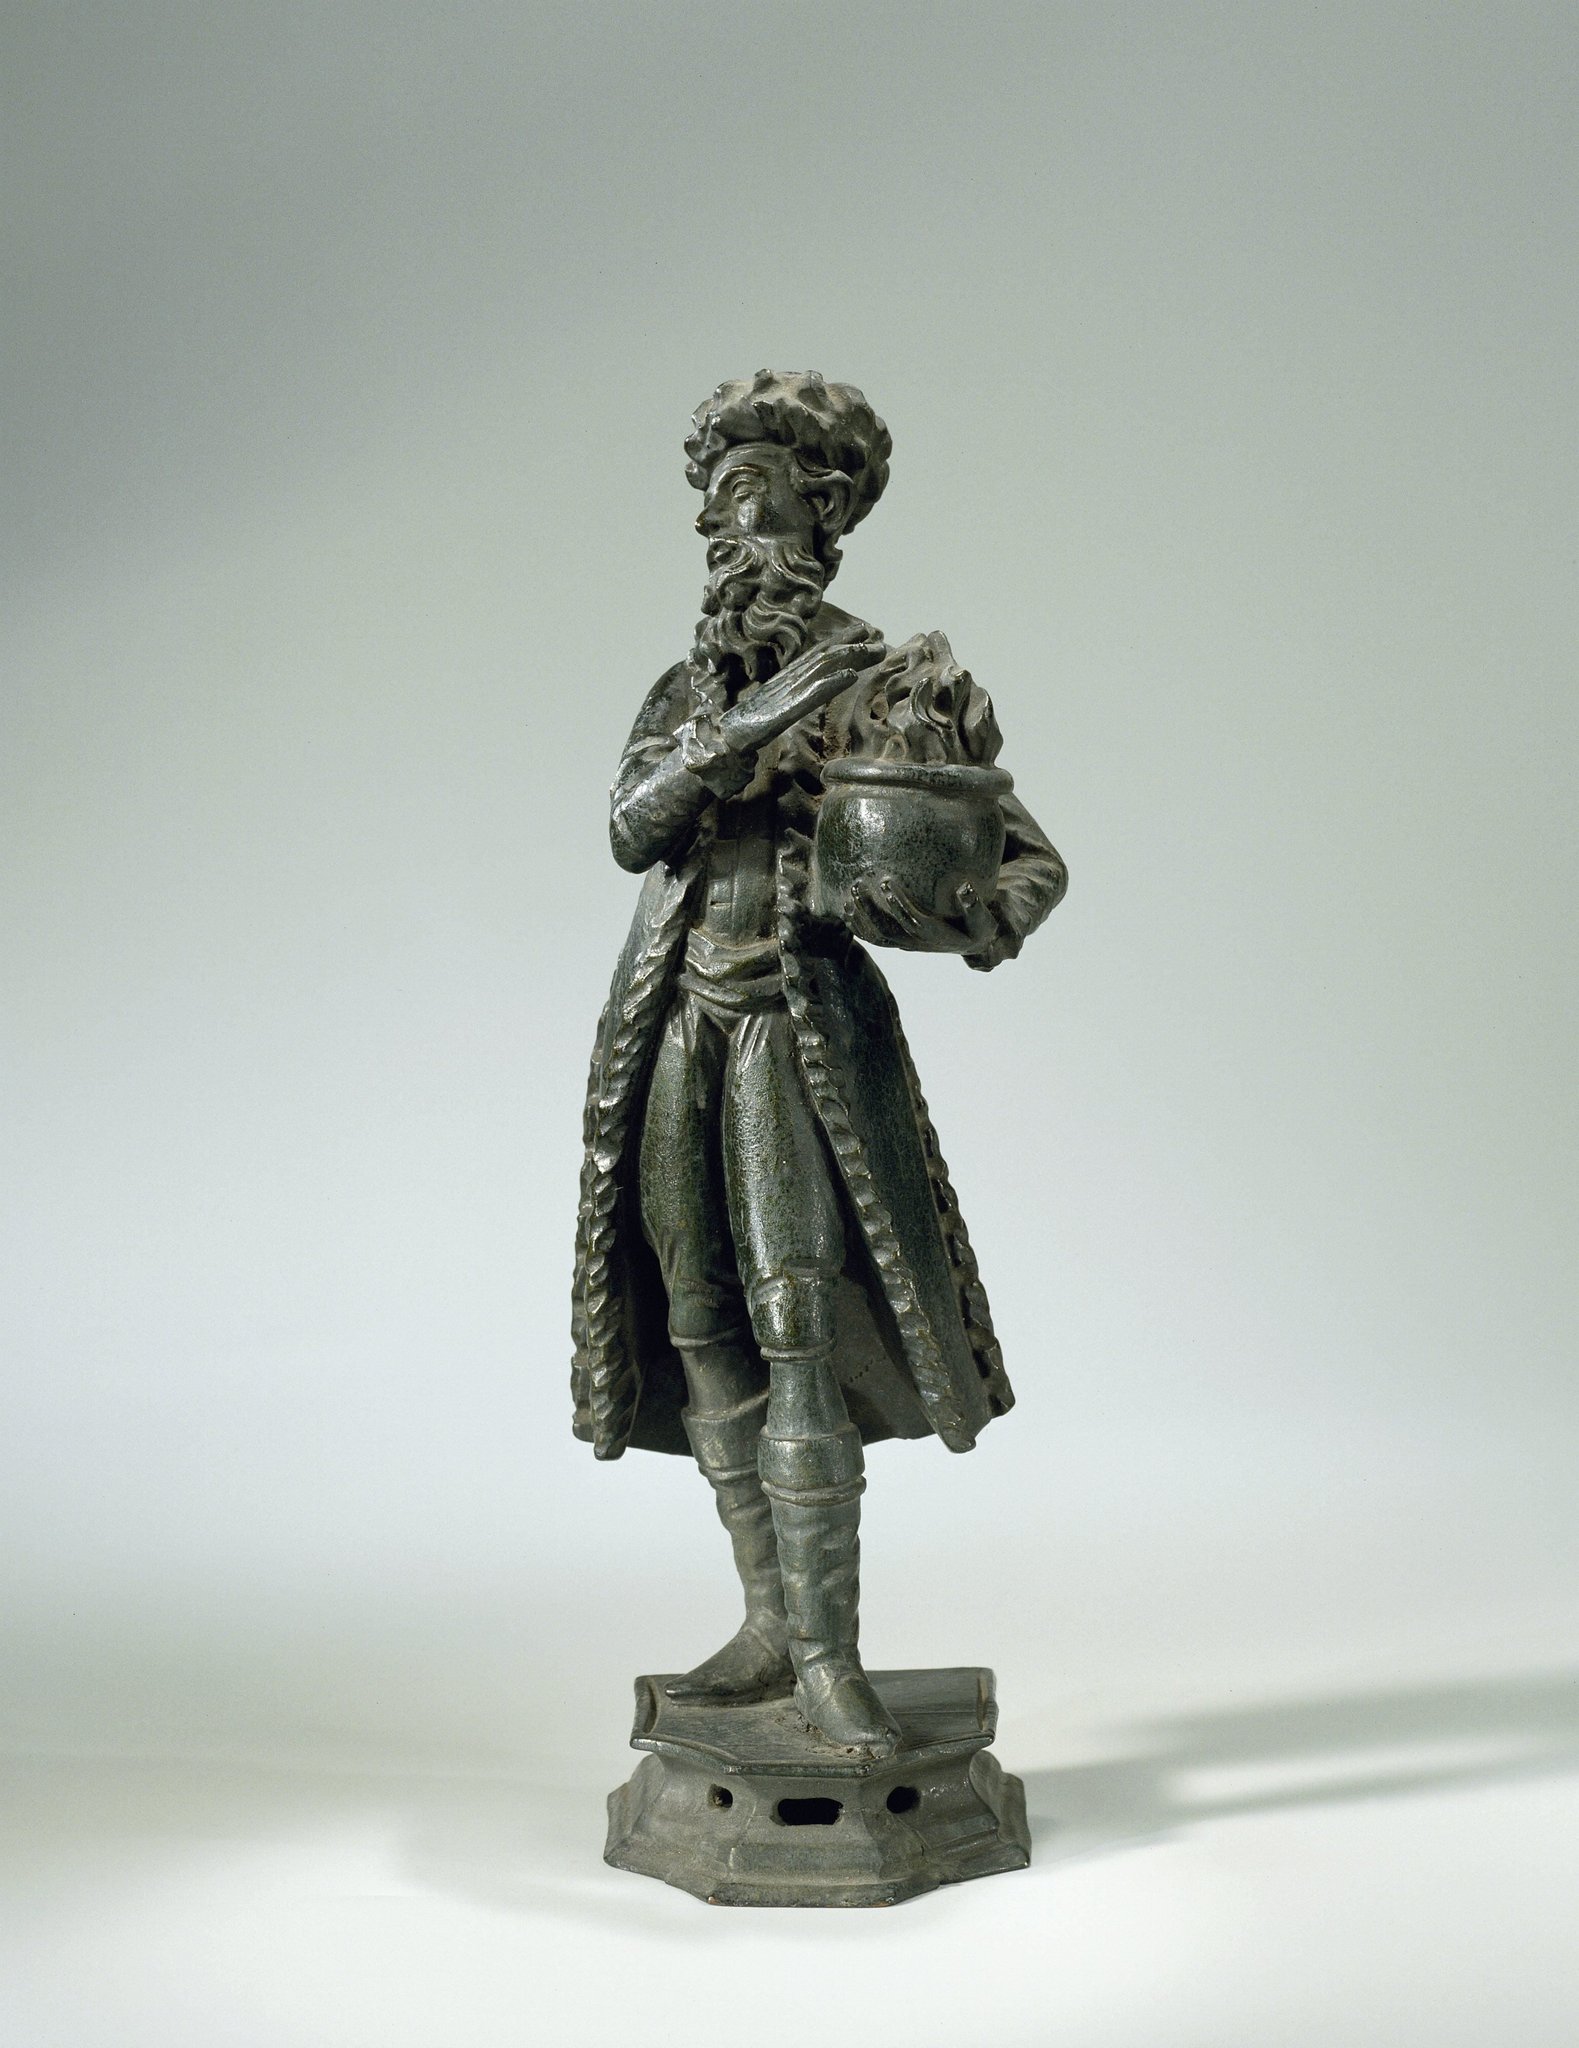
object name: figure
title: Figuur, voorstellende De Winter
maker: Anonymous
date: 1700-1800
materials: wood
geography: oberammergau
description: Figuur, man met vuurpot (De Winter). Op een opengewerkt laag voetstuk.